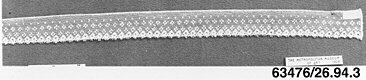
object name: strip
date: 1801-1833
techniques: lace